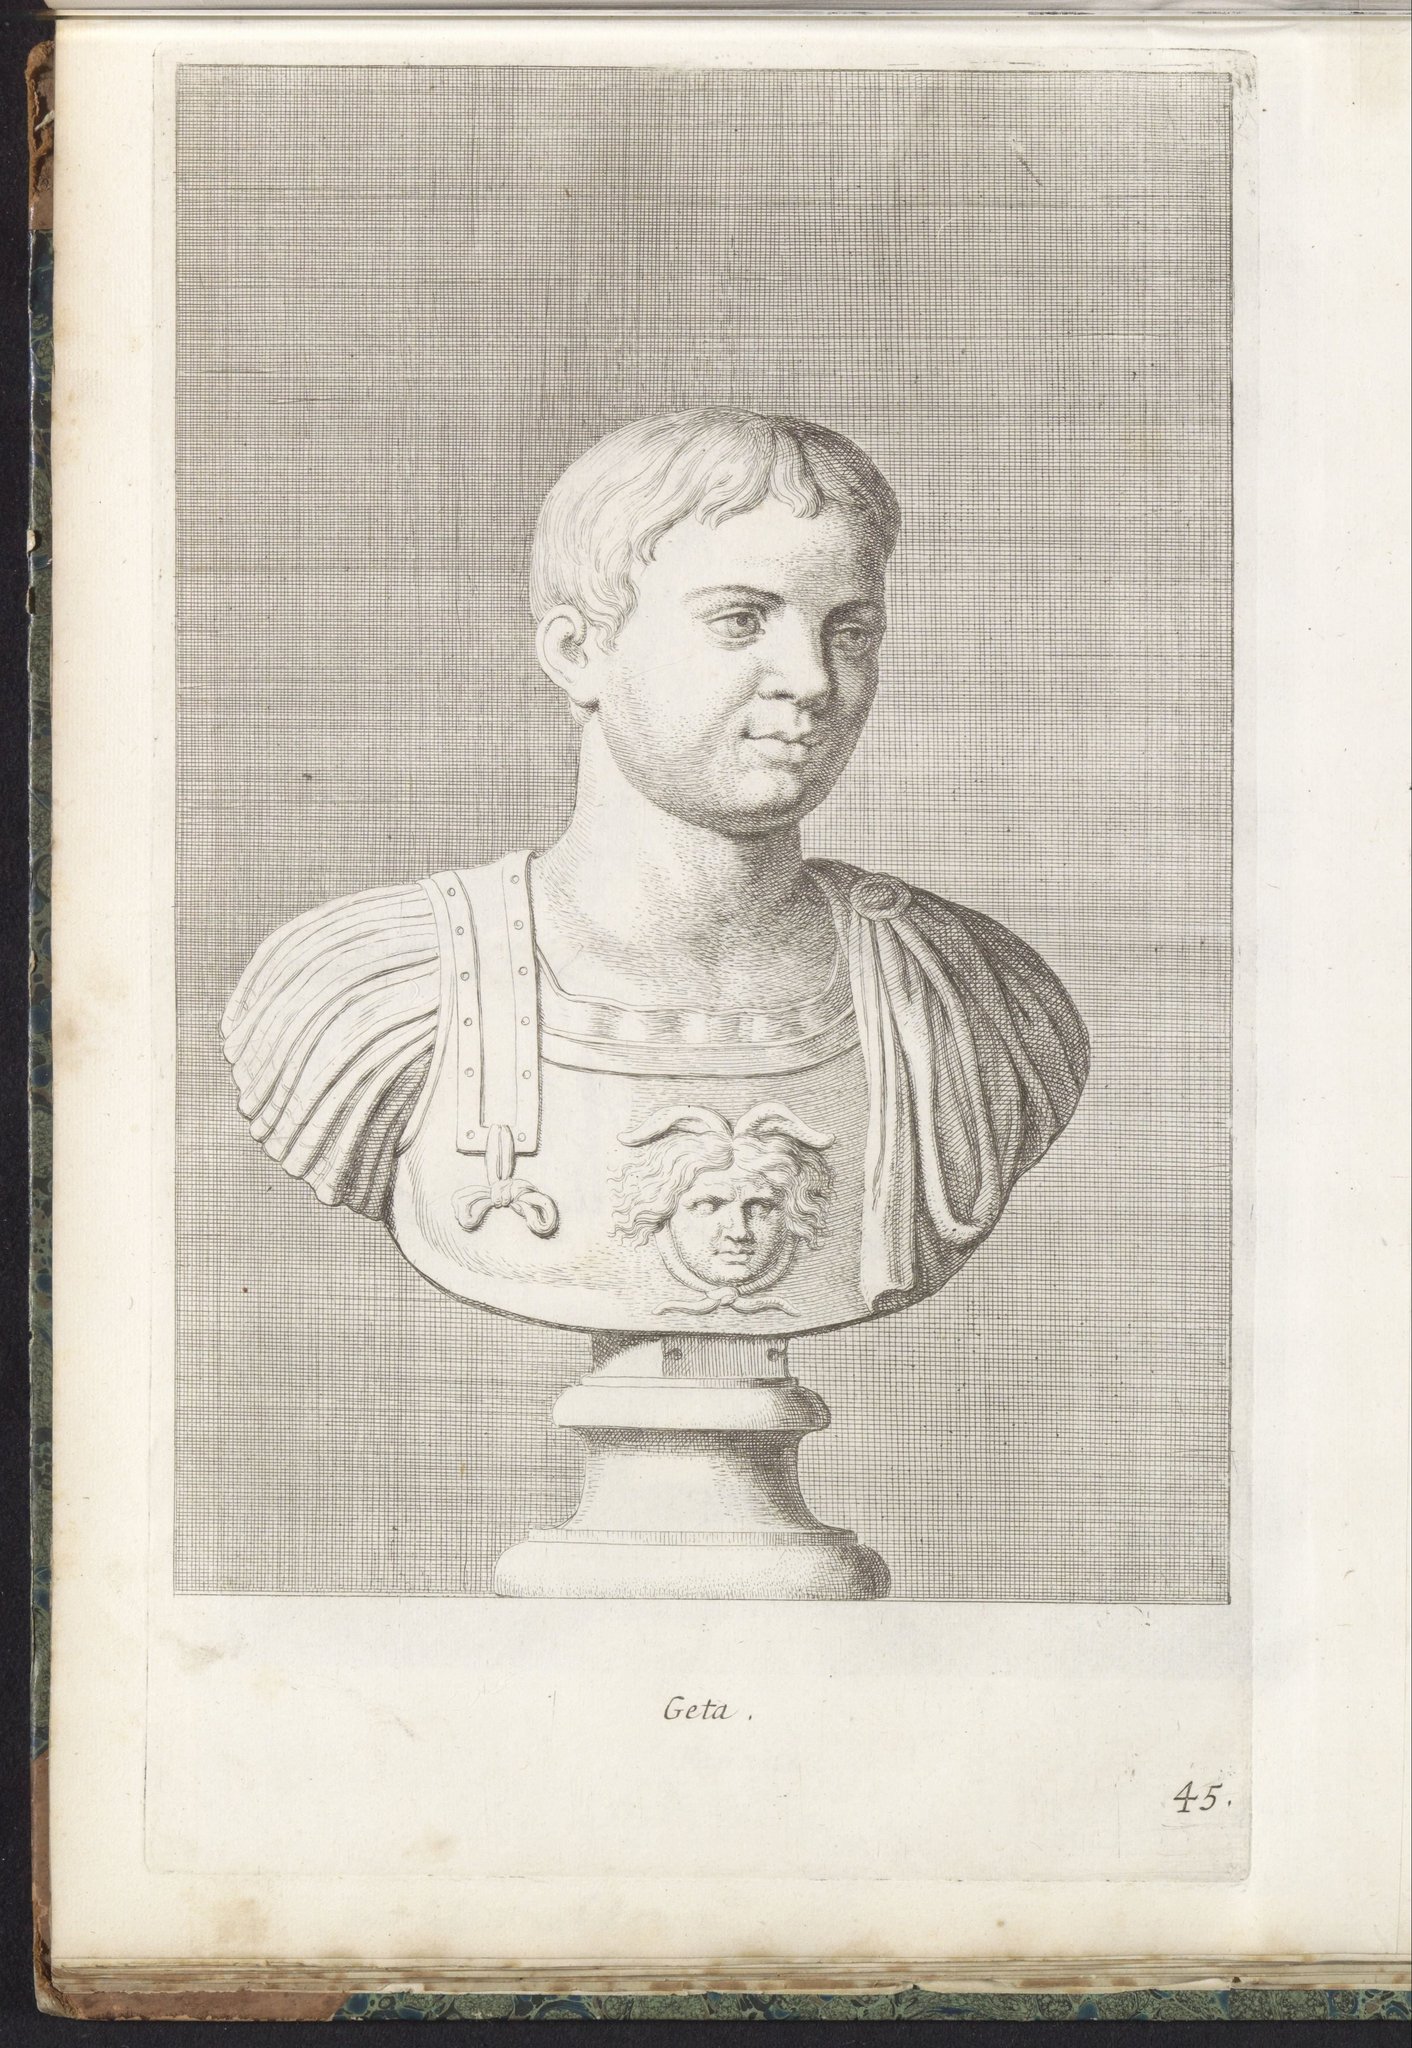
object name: print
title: Geta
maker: hubert quellinus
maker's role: print maker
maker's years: 1619-1687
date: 1646-1670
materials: paper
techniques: engraving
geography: antwerp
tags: piece of sculpture, reproduction of a piece of sculpture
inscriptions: number: ‘62’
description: Klassieke buste van een man in borstharnas met het hoofd van Medusa. De prent maakt deel uit van een album met een serie prenten naar de sculpturen in de verzameling van Gerard Reynst.